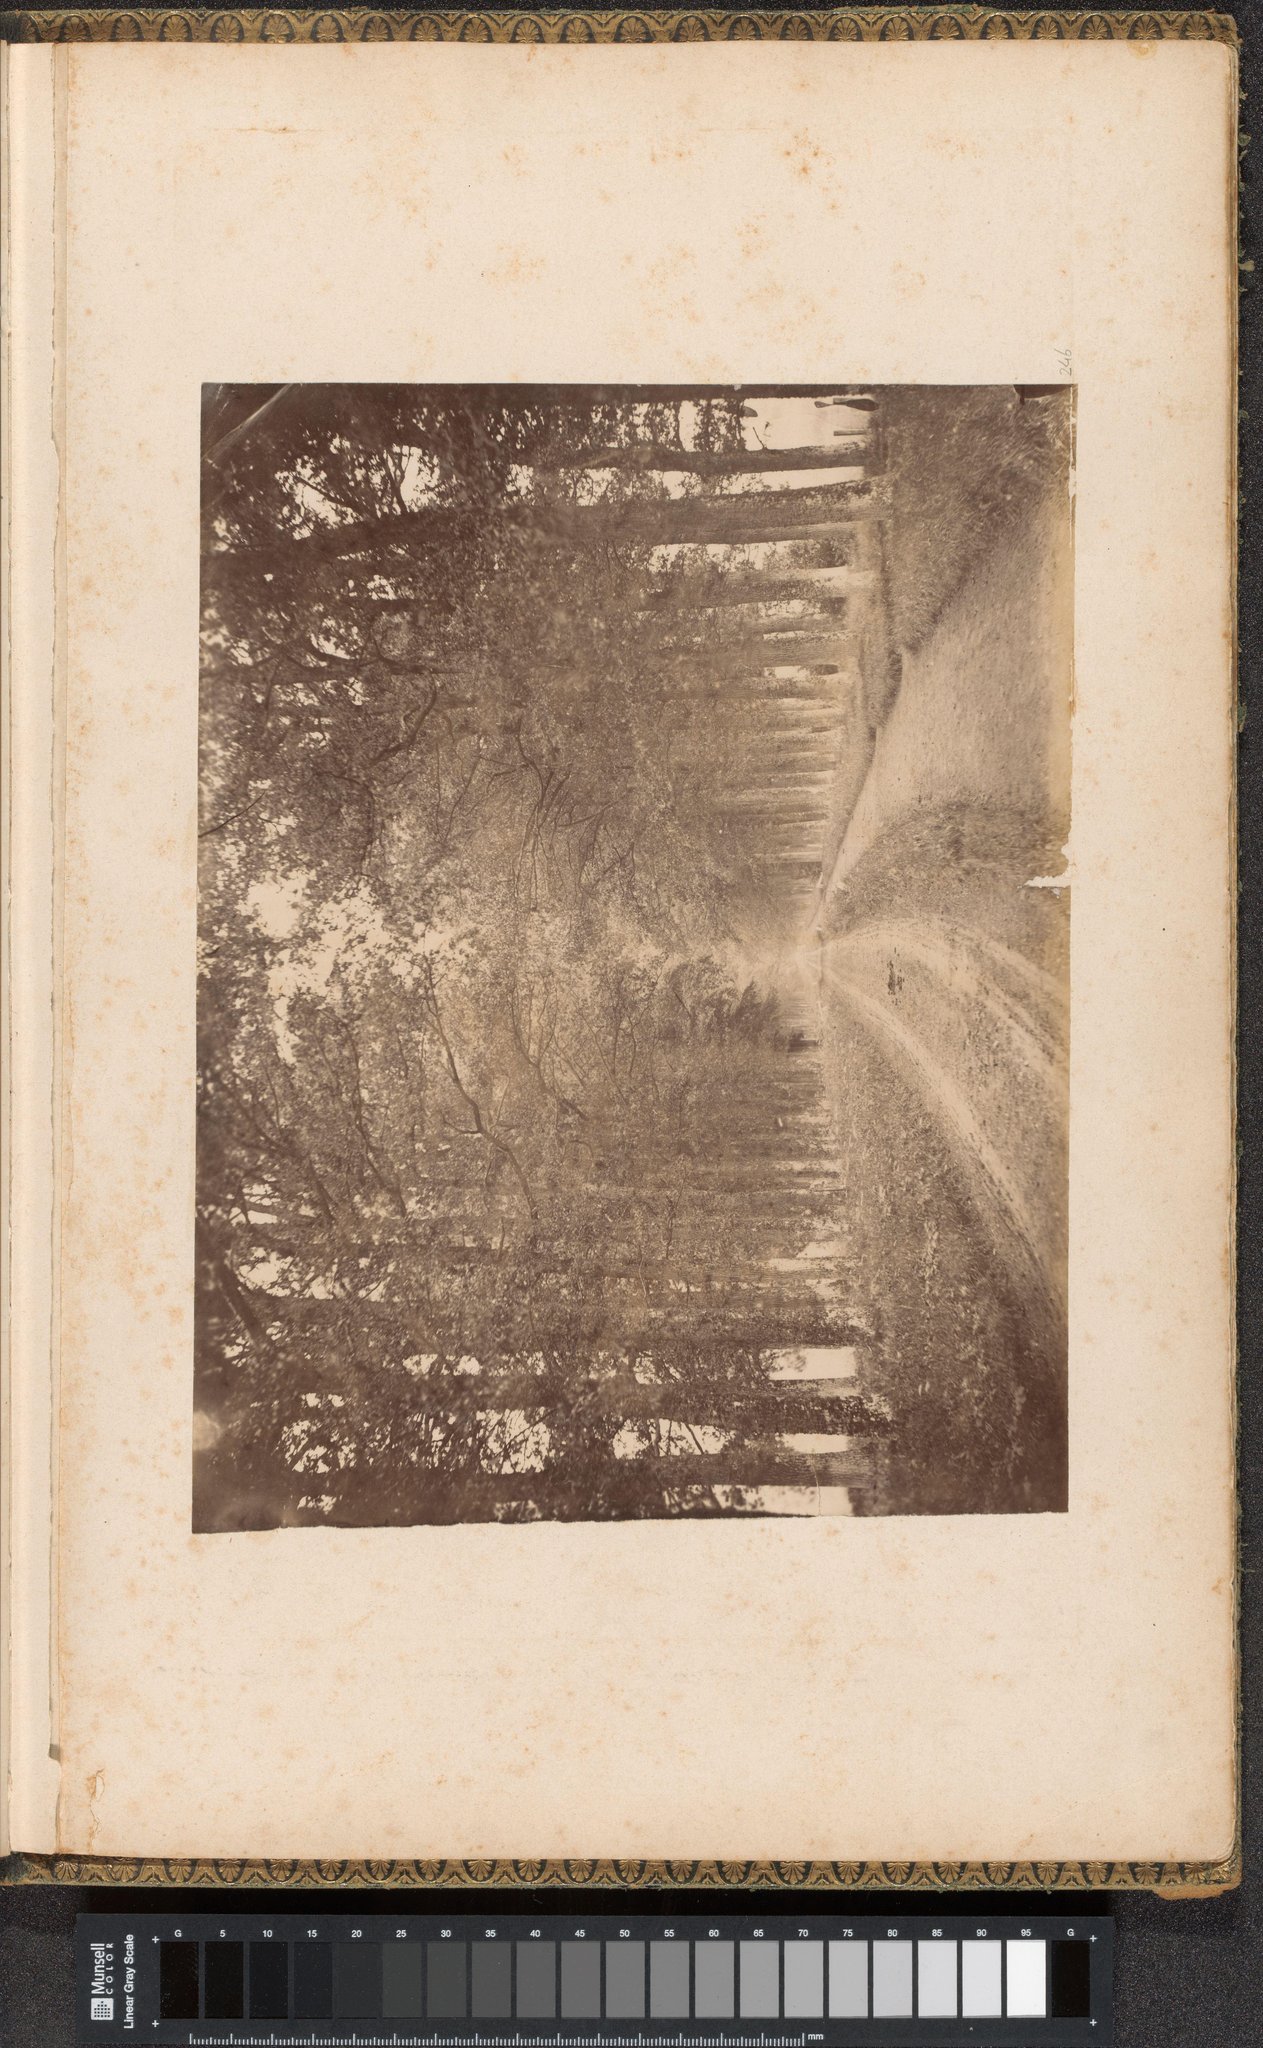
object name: album leaf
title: Laan met wielsporen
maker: Anonymous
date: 1870-1880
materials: paper, photographic support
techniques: albumen print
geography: netherlands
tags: forest path or lane, netherlands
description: Onderdeel van Fotoalbum van Robert Daniel Crommelin (1841-1907).